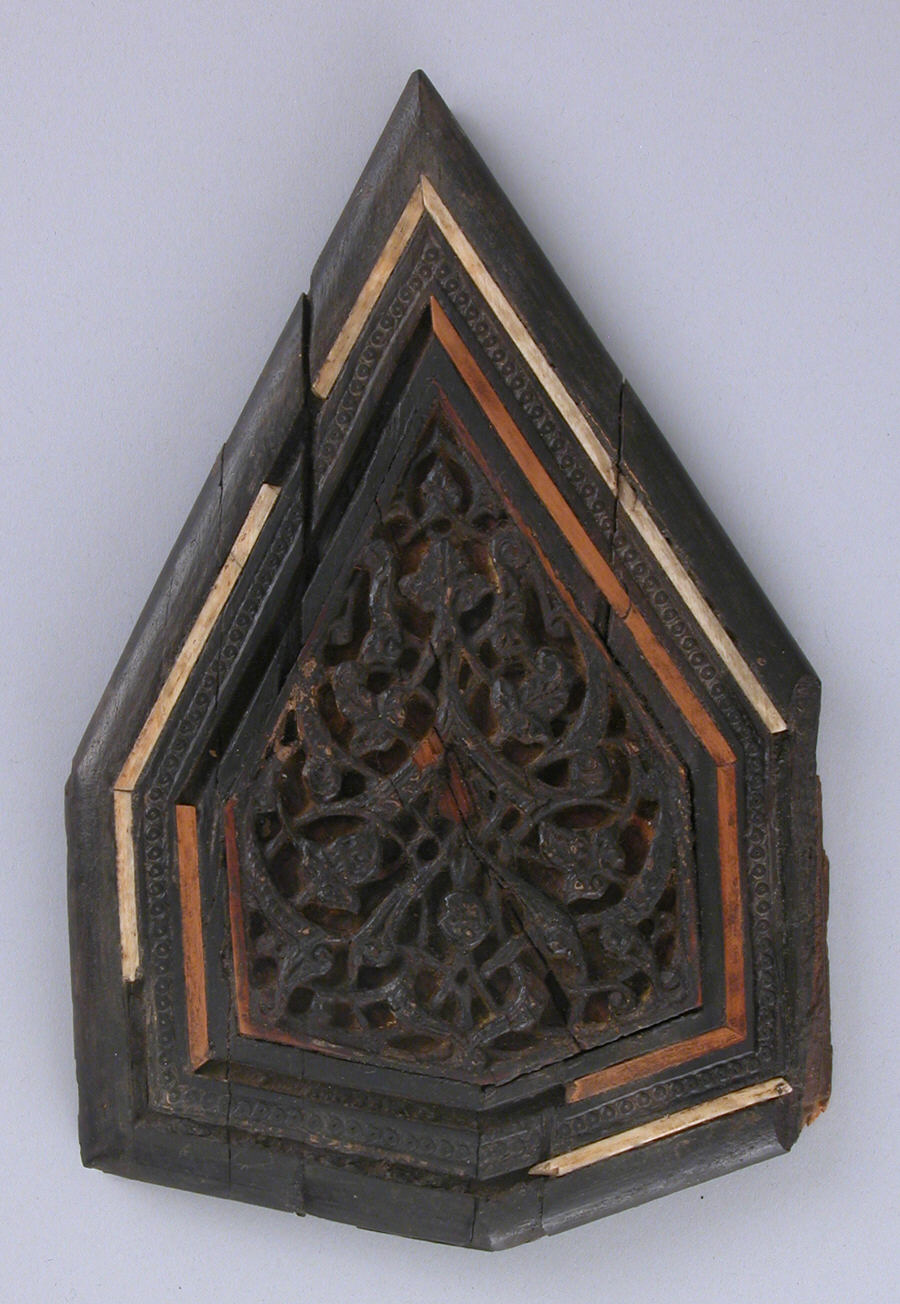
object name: panel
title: Panel from a Minbar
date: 1201-1400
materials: ivory, paint, wood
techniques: carving, inlay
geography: egypt